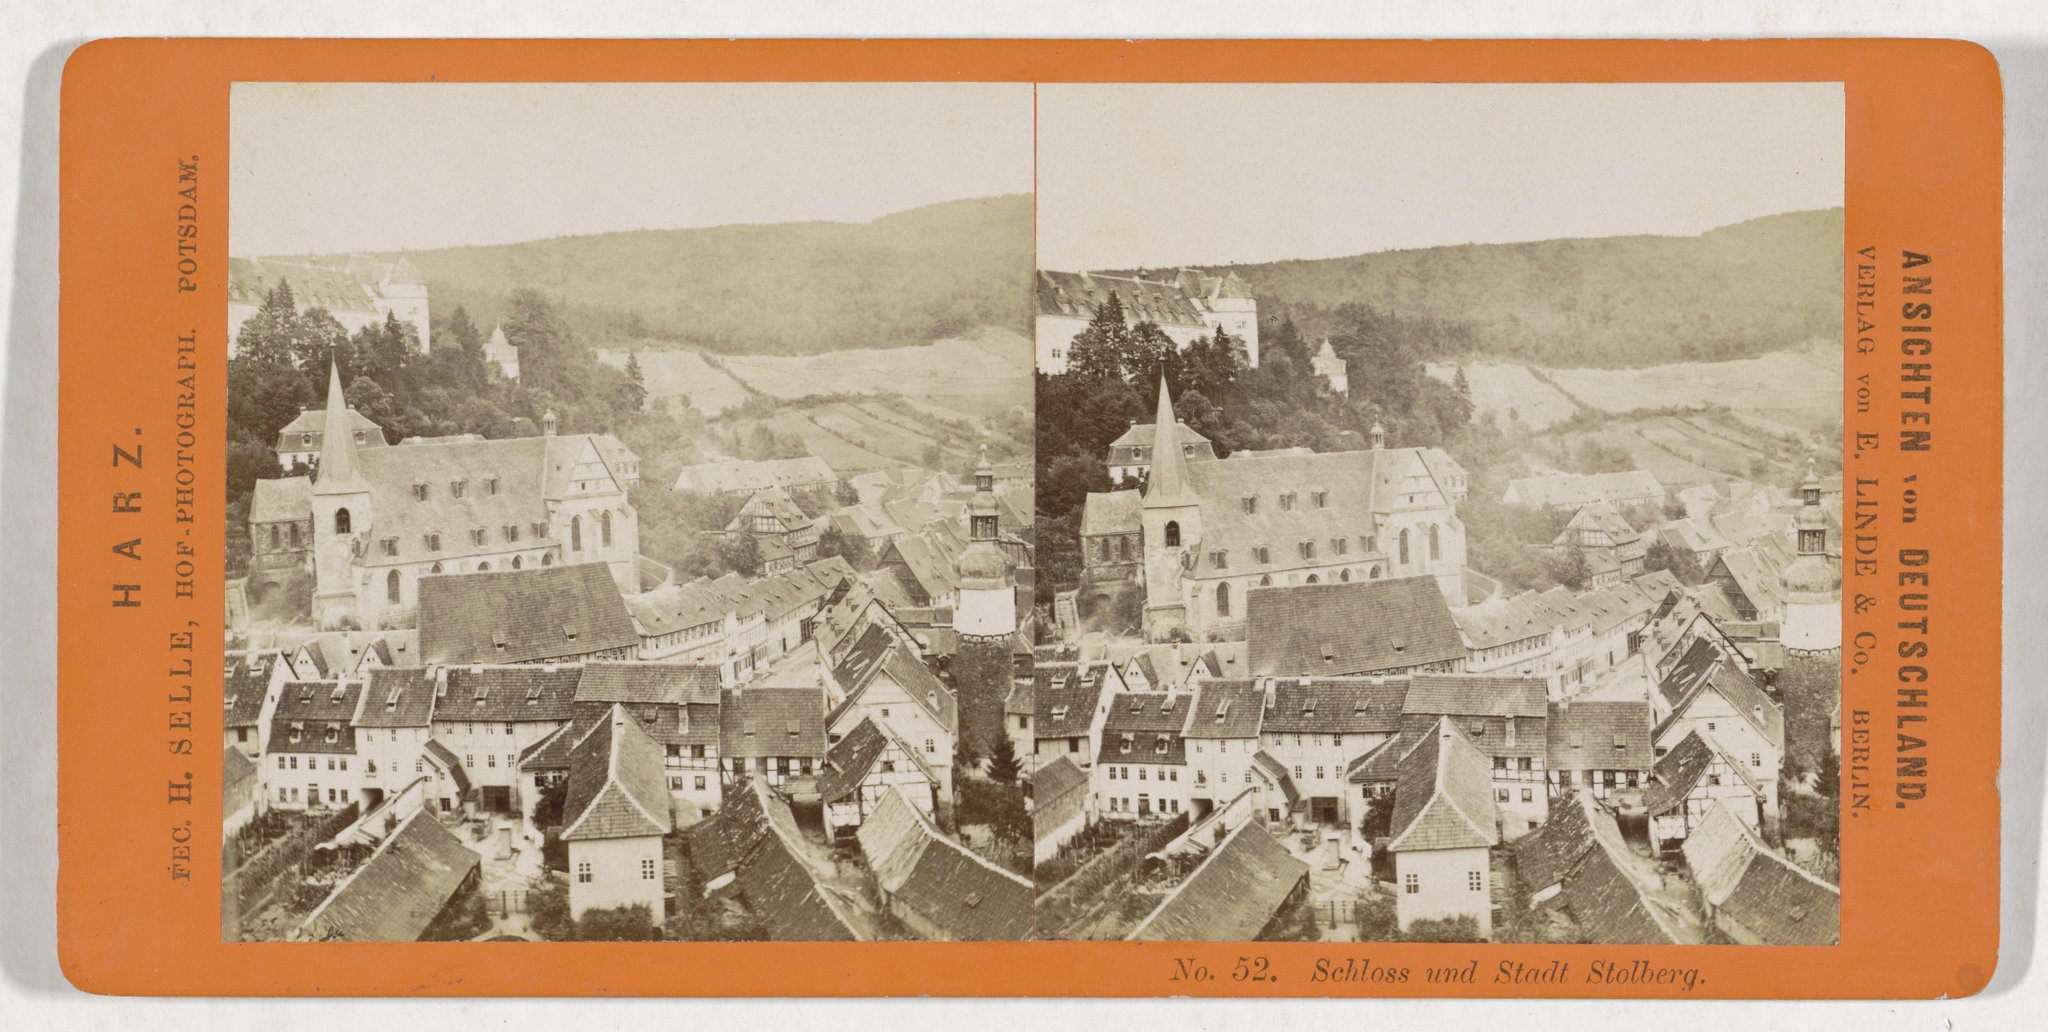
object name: stereograph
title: Gezicht op de stad Stolberg met het kasteel en Sint-Martinikerk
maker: hermann selle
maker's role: fotograaf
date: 1868-1890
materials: cardboard, paper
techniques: albumen print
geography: berlin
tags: city-view in general; 'veduta', church (exterior)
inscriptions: number: ‘No. 52.’, inscription: ‘Hof-Photograph. Potsdam.’